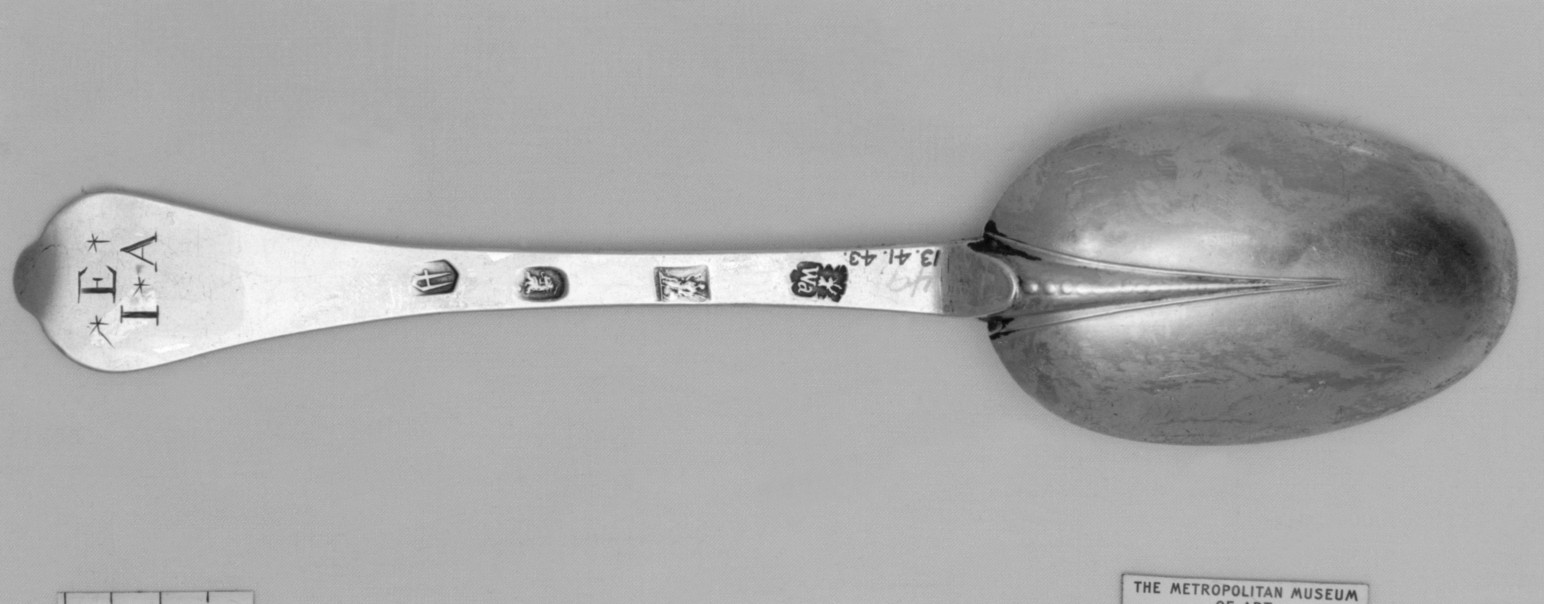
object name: spoon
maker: benjamin watts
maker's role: maker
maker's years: 1698-1727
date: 1701-1702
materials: silver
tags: human figures,animals